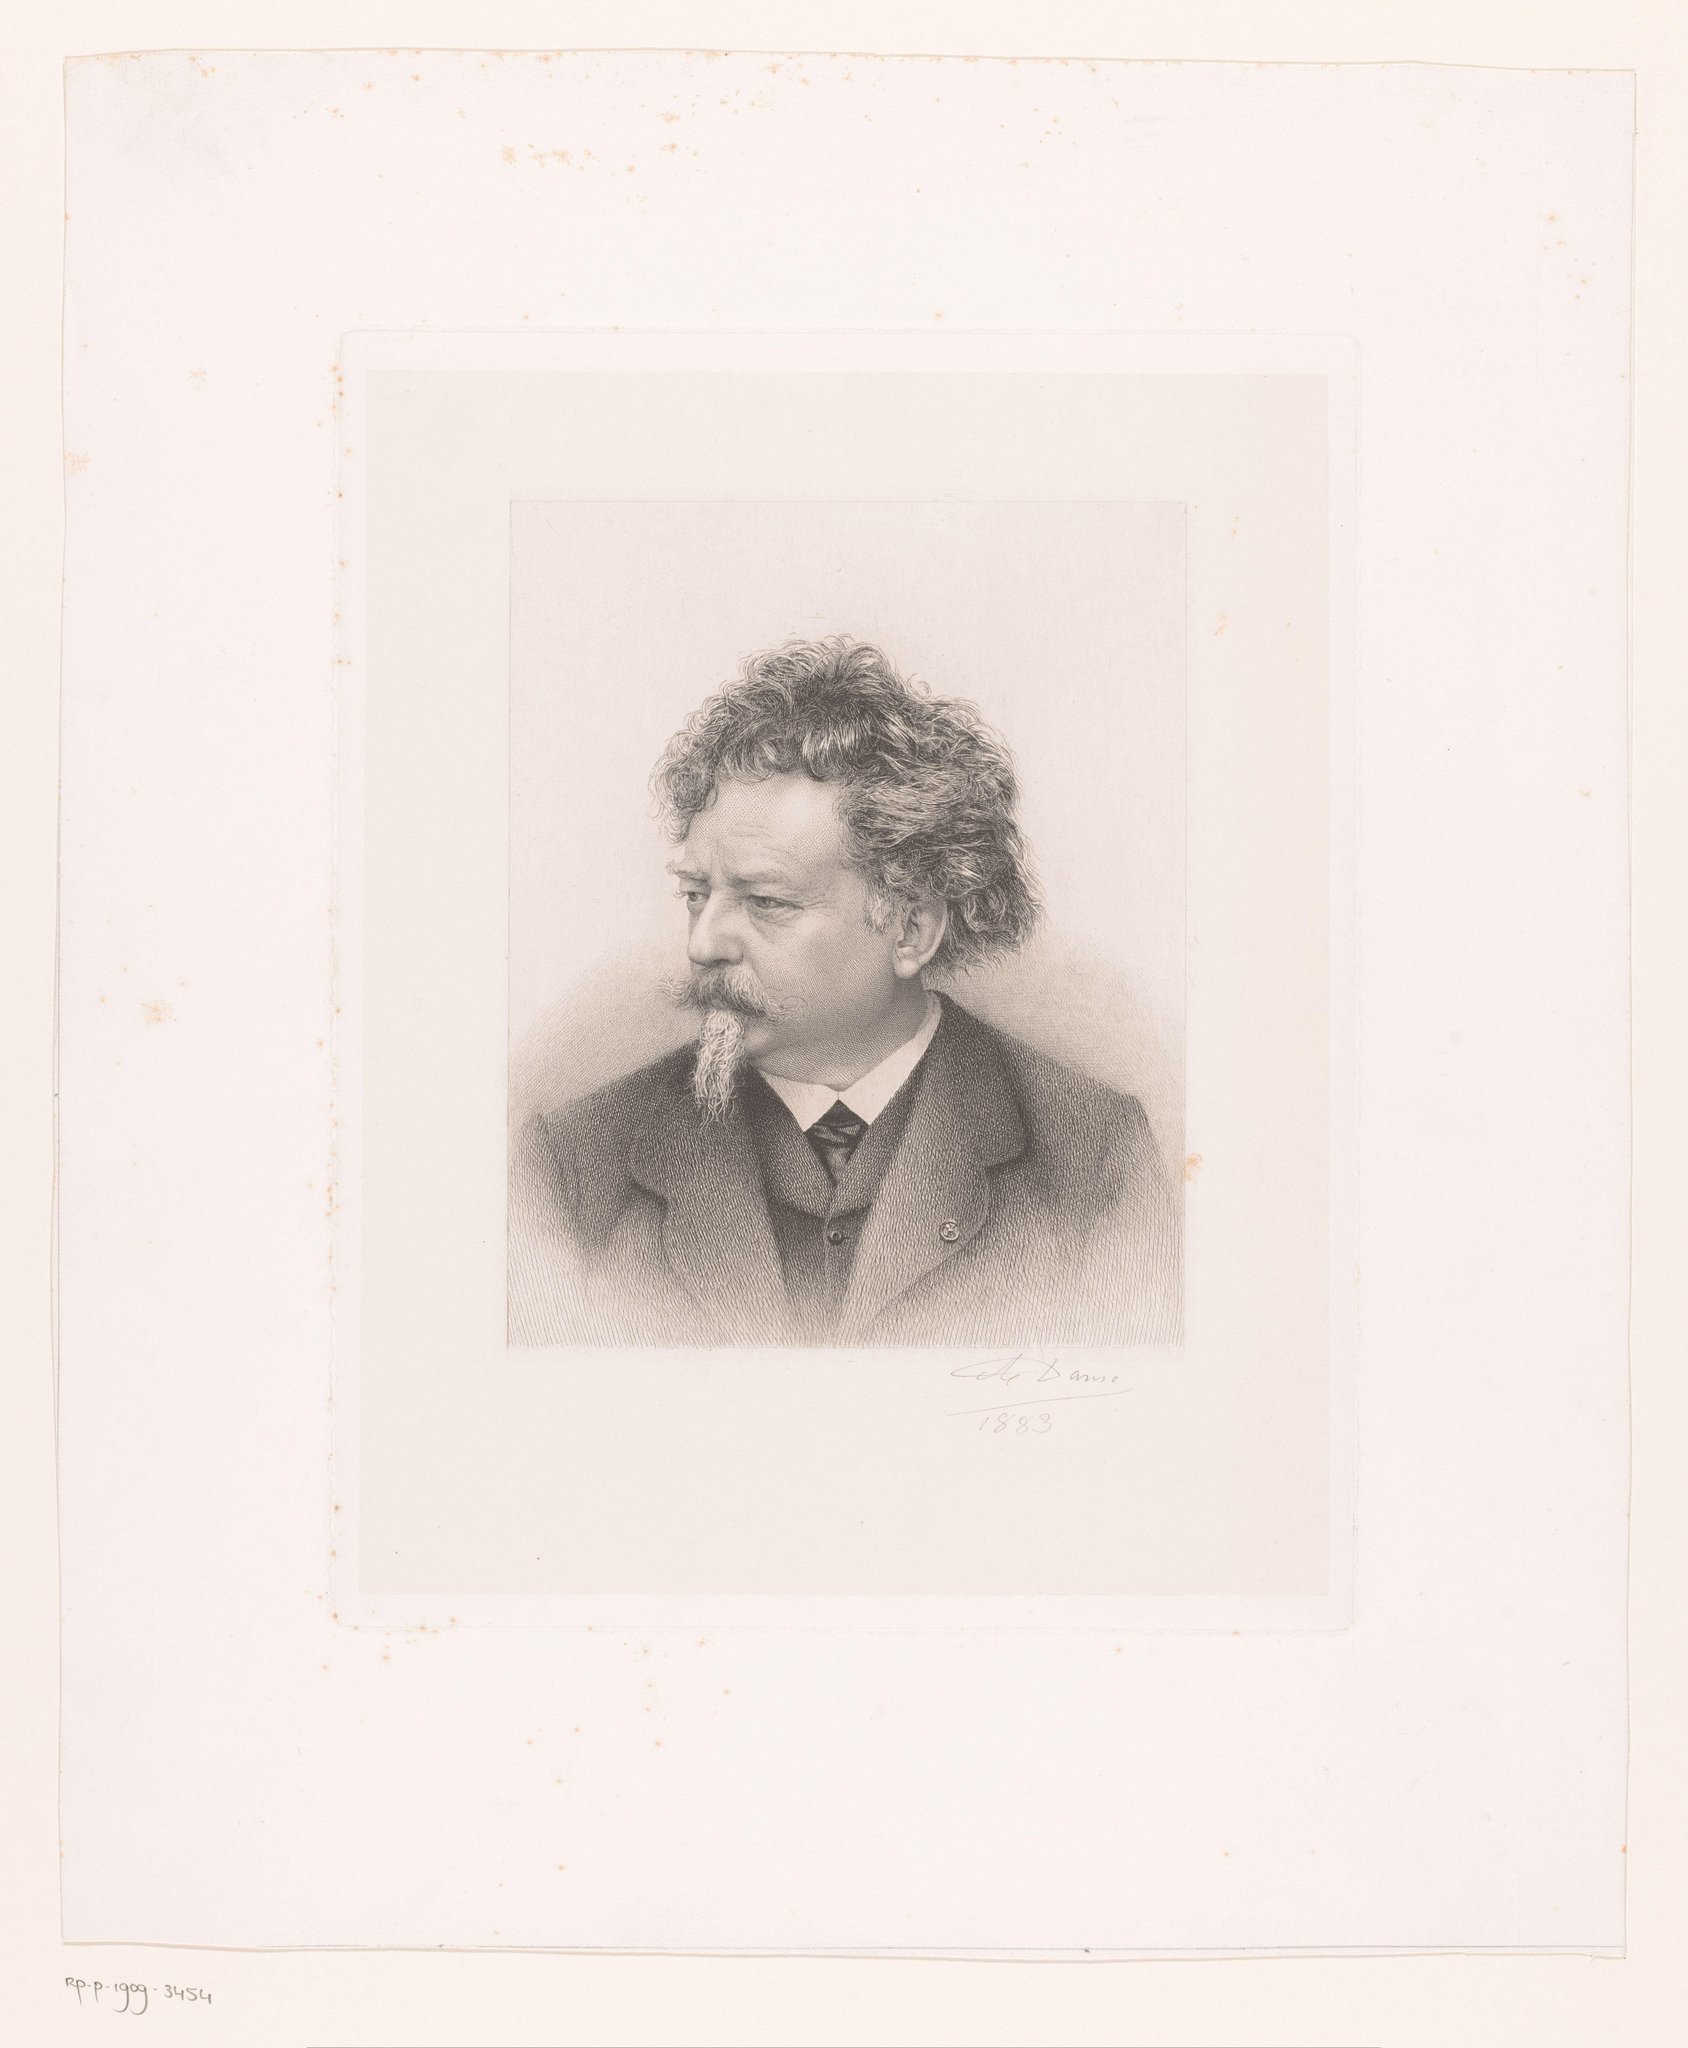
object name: print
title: Portret van een onbekende man, mogelijk Bouvé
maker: auguste danse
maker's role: print maker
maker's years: 1829-1929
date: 1883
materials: paper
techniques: etching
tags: anonymous historical person portrayed alone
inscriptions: collector's mark: Lugt 2228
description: De identificatie Bouvé is gebaseerd op een potloodaantekening op een eerdere staat in de collectie van het Rijksmuseum Amsterdam.